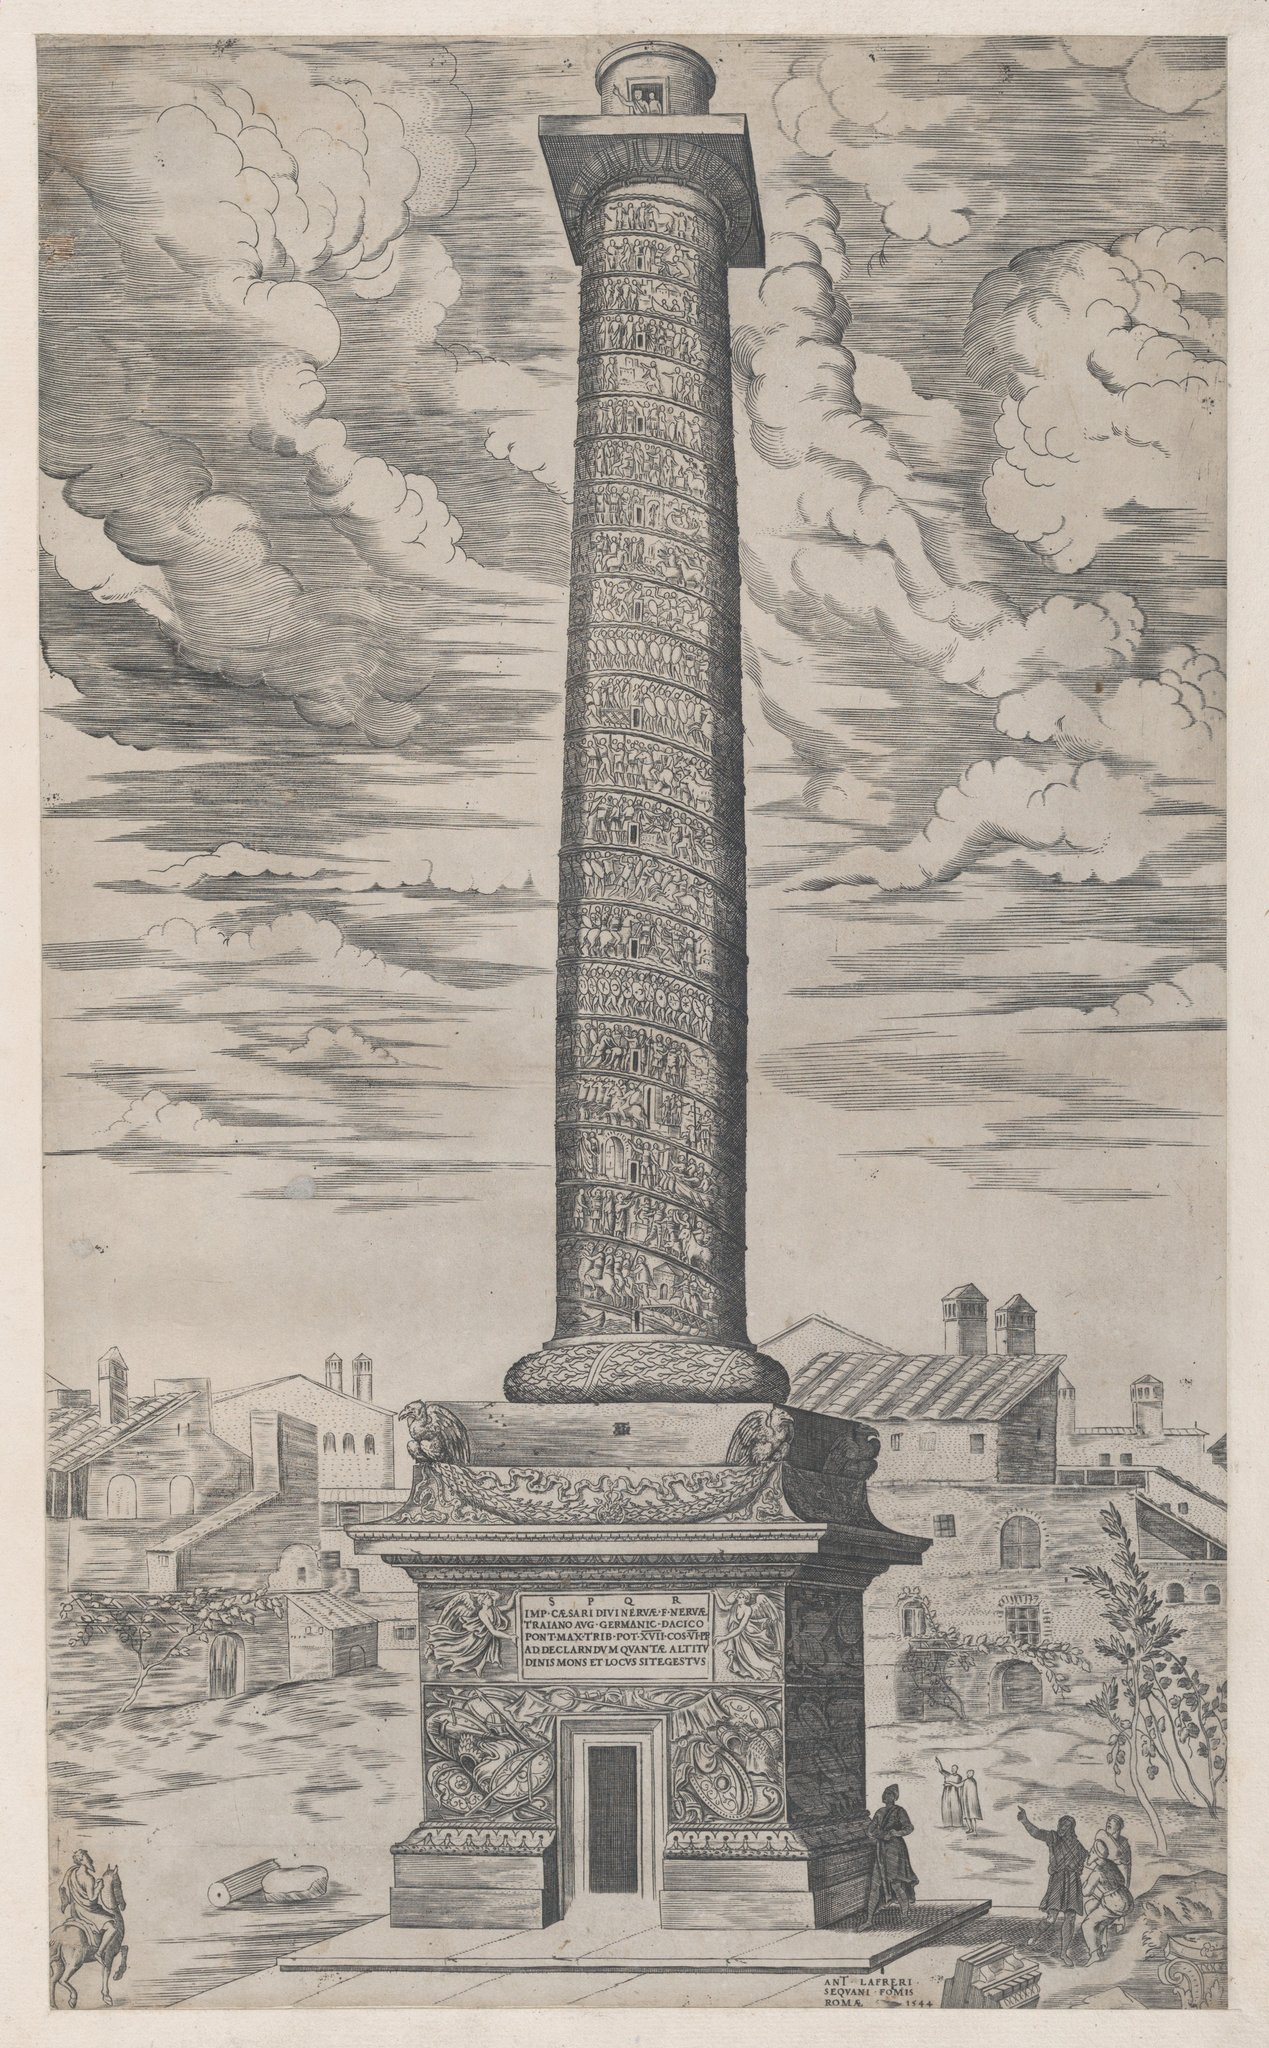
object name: print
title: Column of Trajan, from "Speculum Romanae Magnificentiae"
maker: Anonymous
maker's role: artist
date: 1544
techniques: engraving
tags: columns,rome